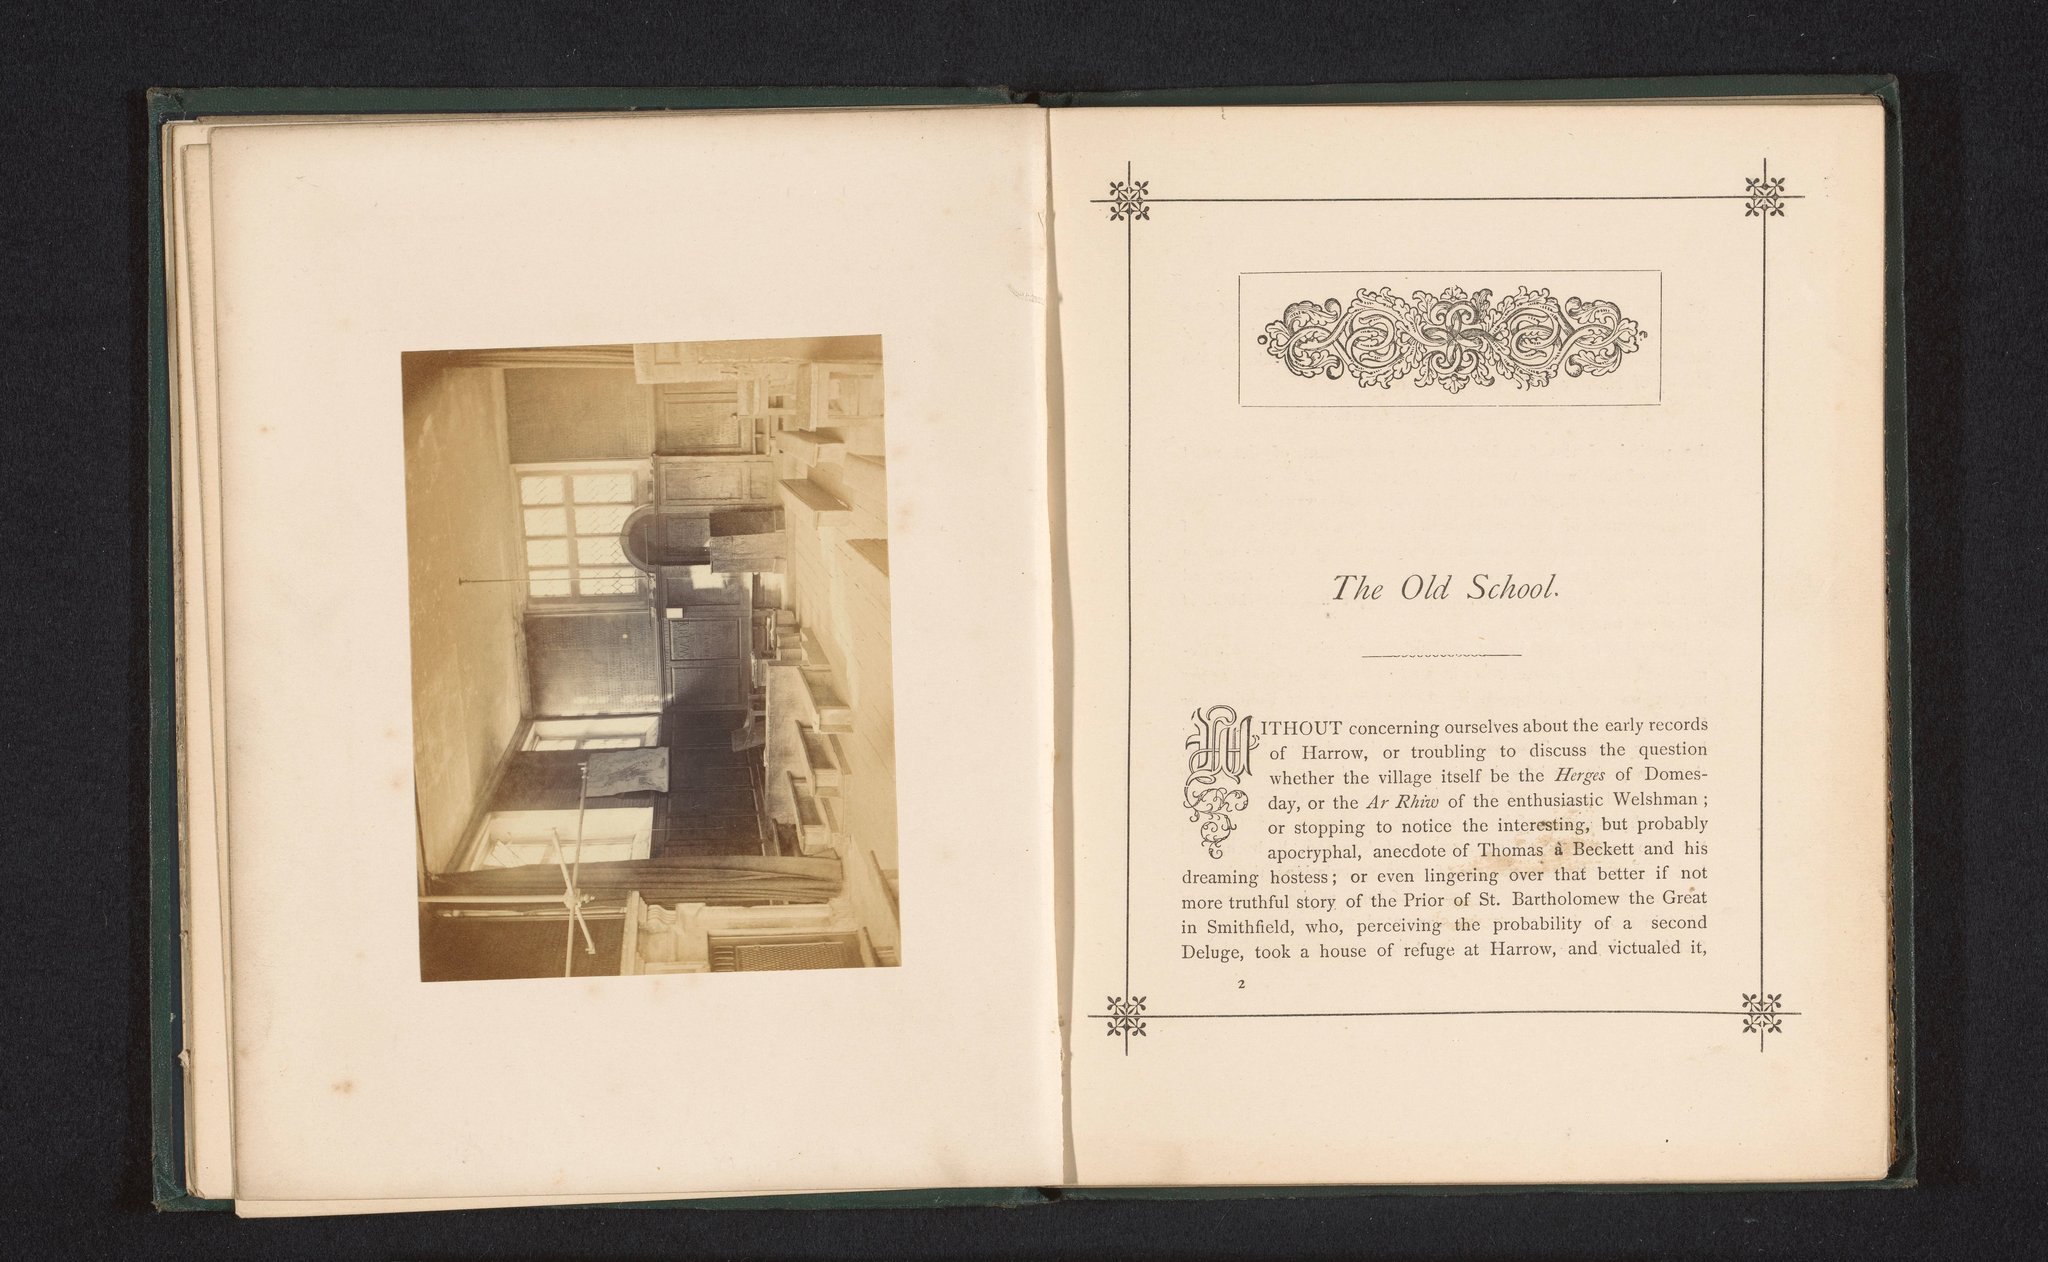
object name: page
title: Interieur van Harrow School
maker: william russell sedgfield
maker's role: fotograaf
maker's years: 1826-1902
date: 1860-1870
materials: photographic support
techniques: albumen print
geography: harrow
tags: secondary education, interior ~ representation of a building